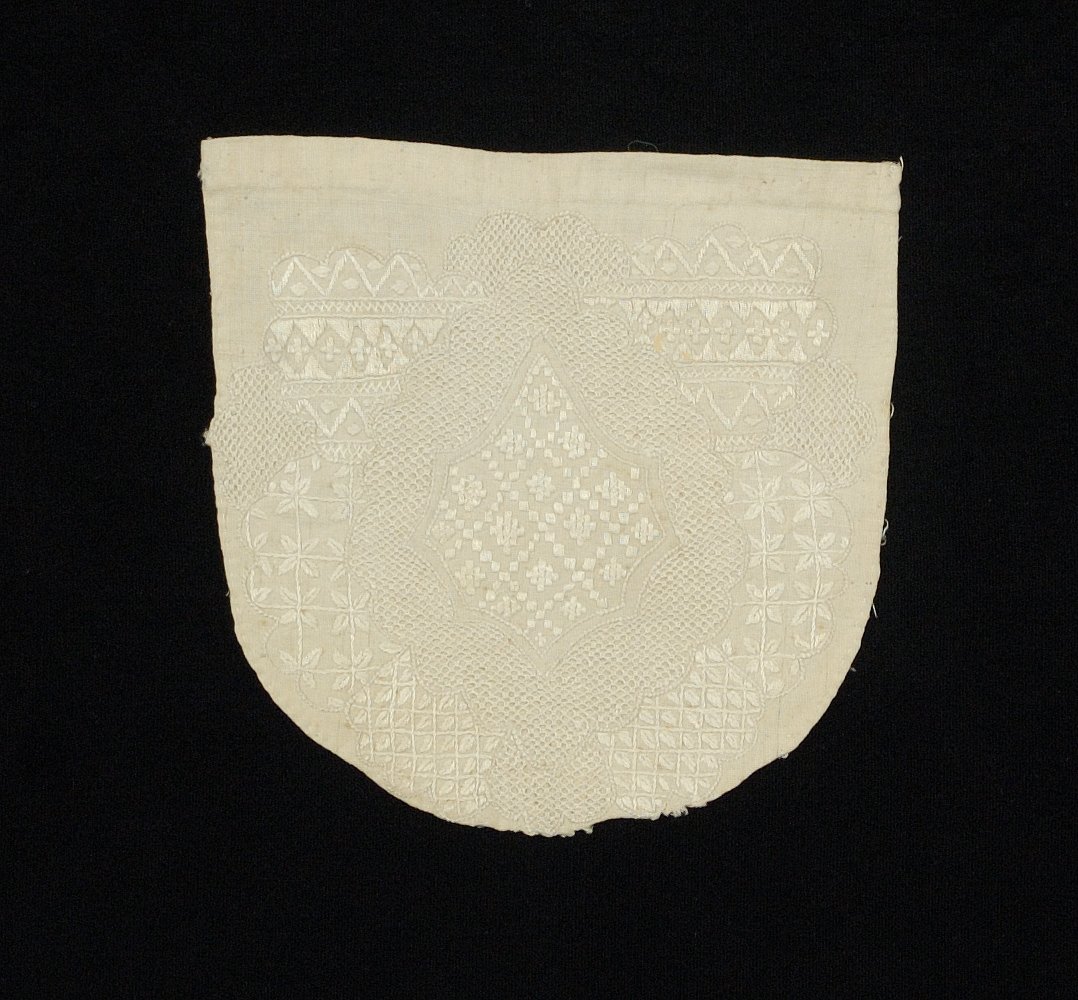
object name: pocket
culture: italian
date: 1740-1770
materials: linen